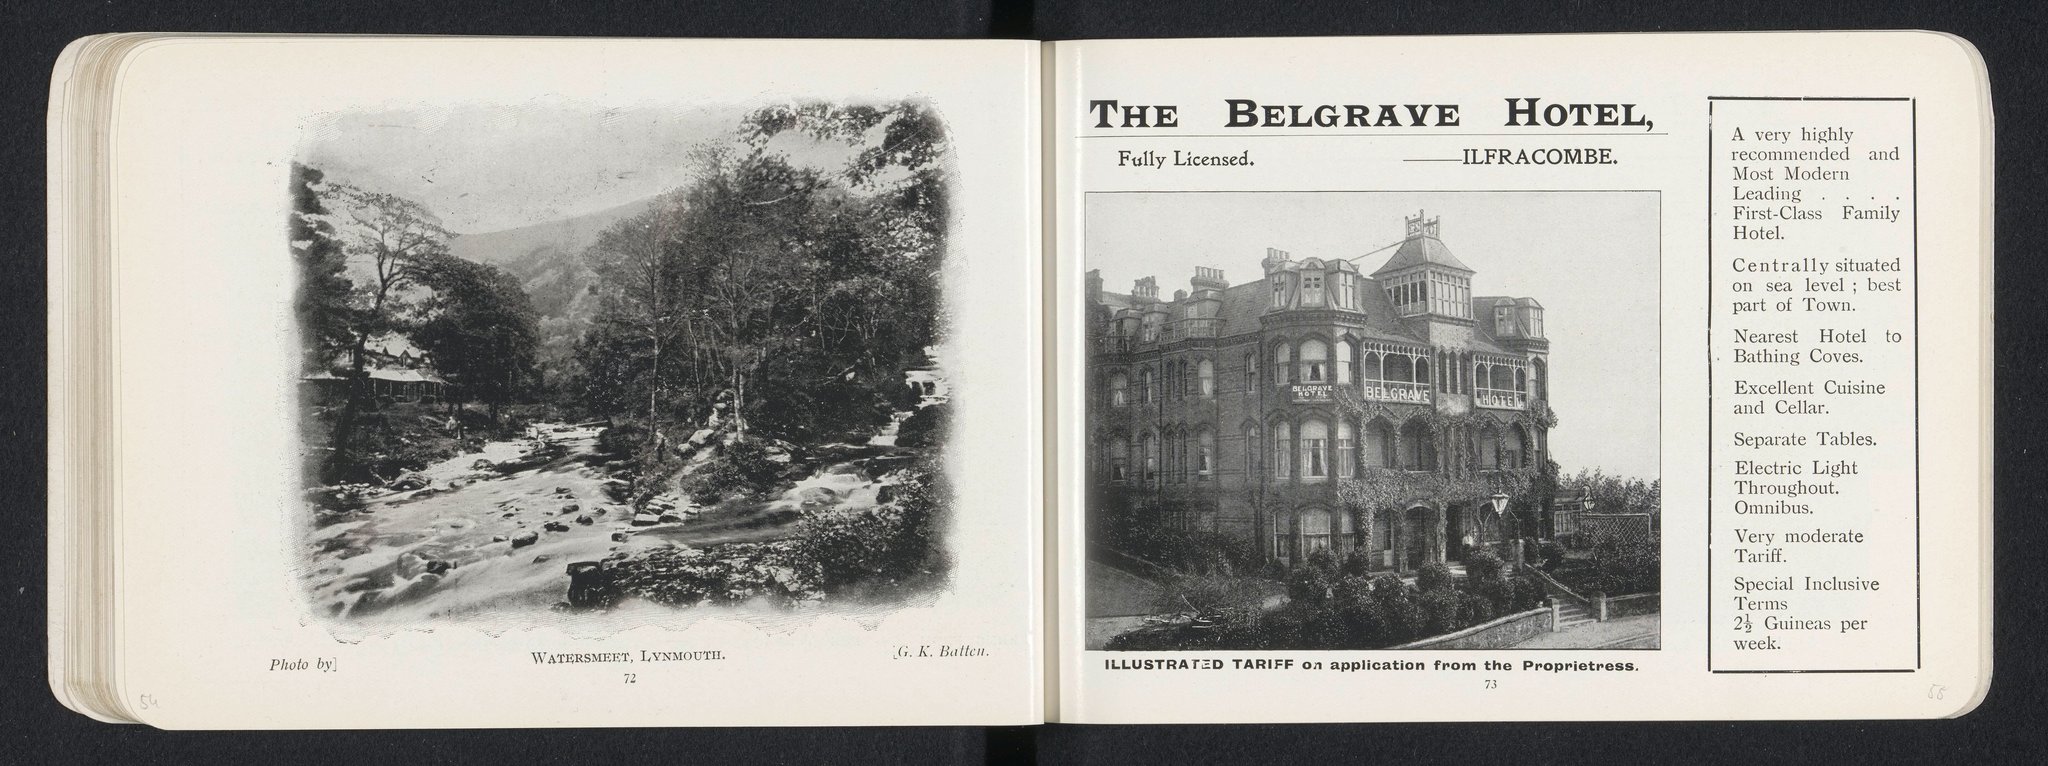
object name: photomechanical print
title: Gevel van het Belgrave Hotel te Ilfracombe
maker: Anonymous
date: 1900-1920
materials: paper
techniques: autotype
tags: façade (of house or building), hotel, hostelry, inn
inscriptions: inscription: ‘The Belgrave Hotel (...) from the Proprietress.’